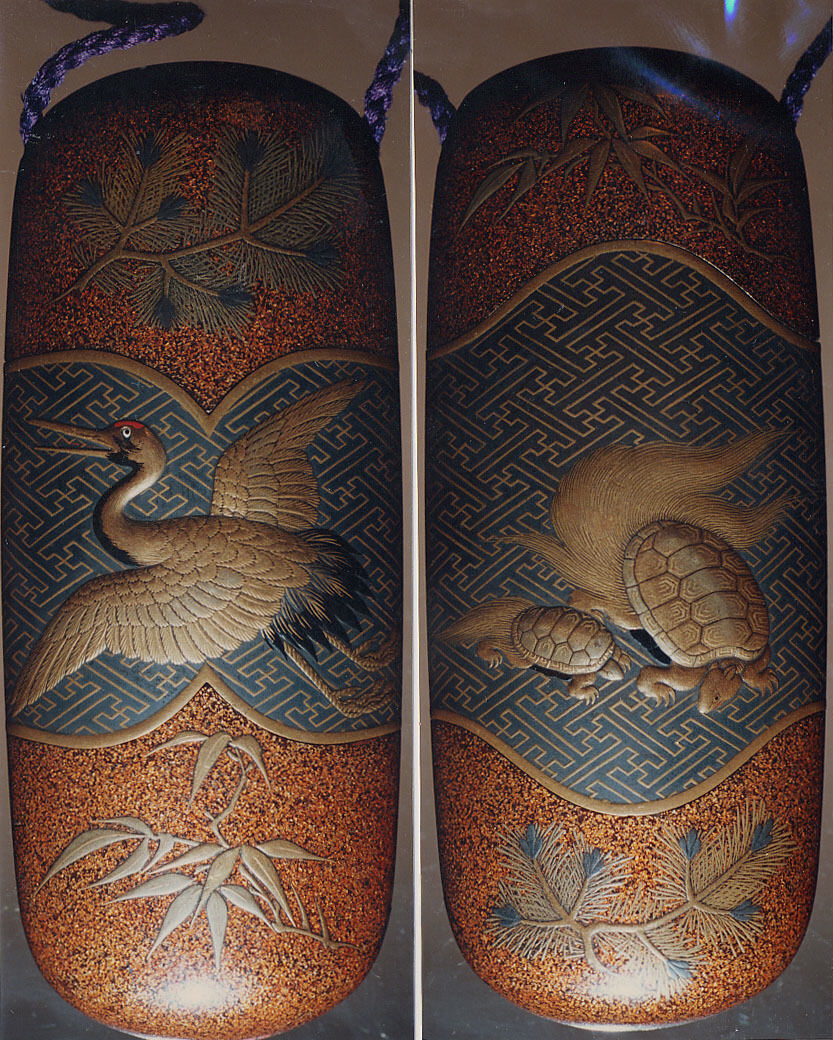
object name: inrō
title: Case (Inrō) with Design of Long-Haired Turtles (obverse); Stork with Pine Sprigs (reverse)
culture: japanese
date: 1801-2000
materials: gold, lacquer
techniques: fundame, hiramakie, inlay, maki-e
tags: birds,turtles